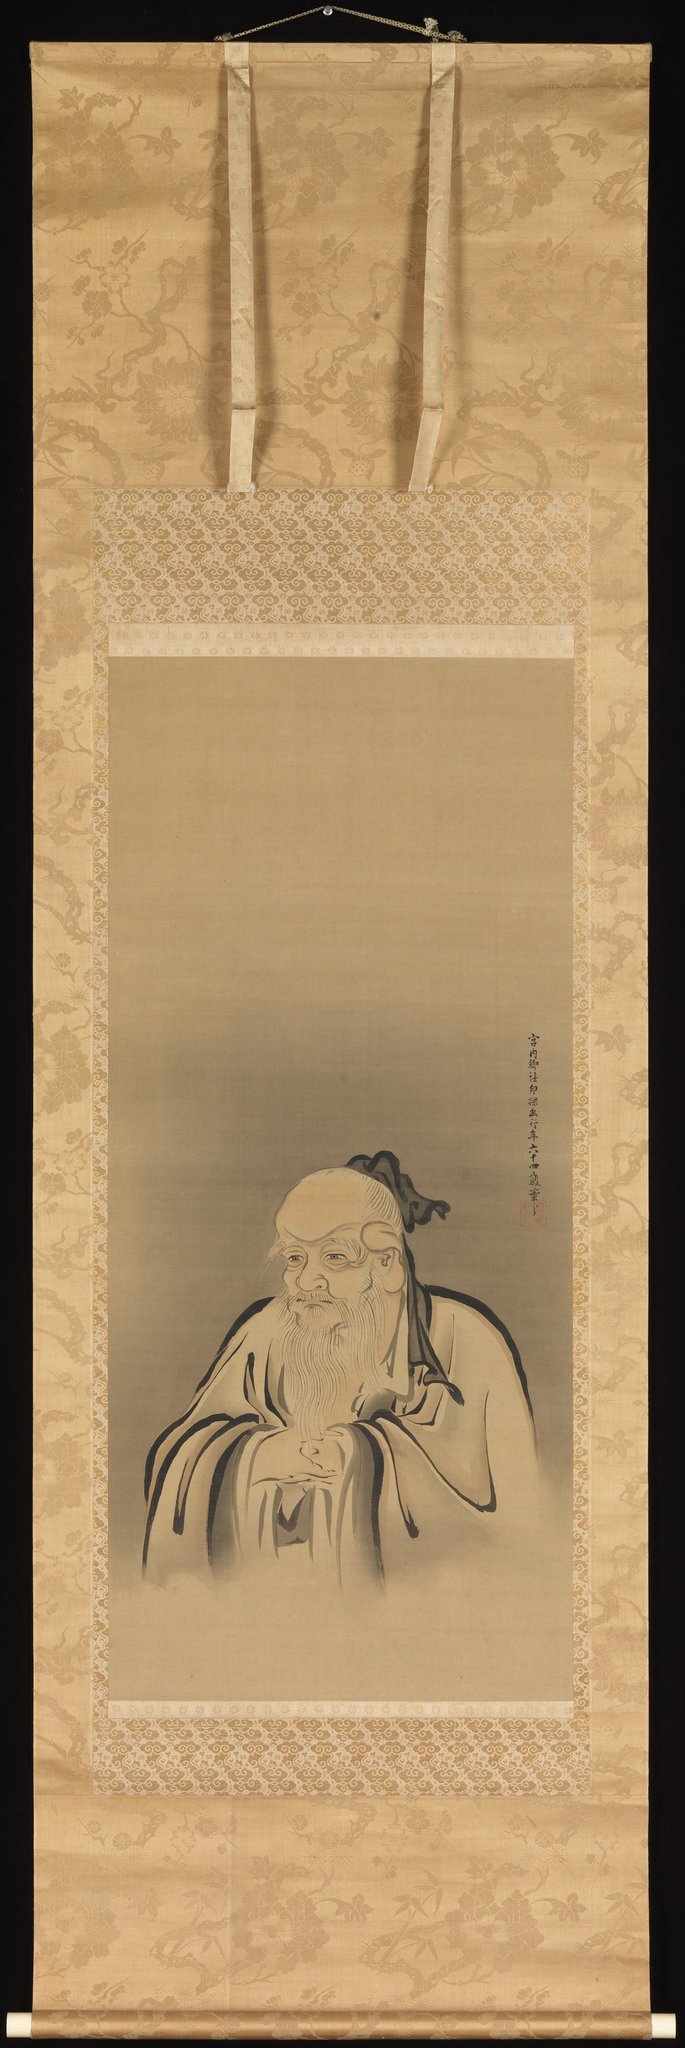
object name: hanging scroll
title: Portrait of Emperor Shennong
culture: japanese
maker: kano tan'yū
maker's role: artist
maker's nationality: japanese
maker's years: 1602-1674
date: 1665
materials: ink, silk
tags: emperors,men,portraits